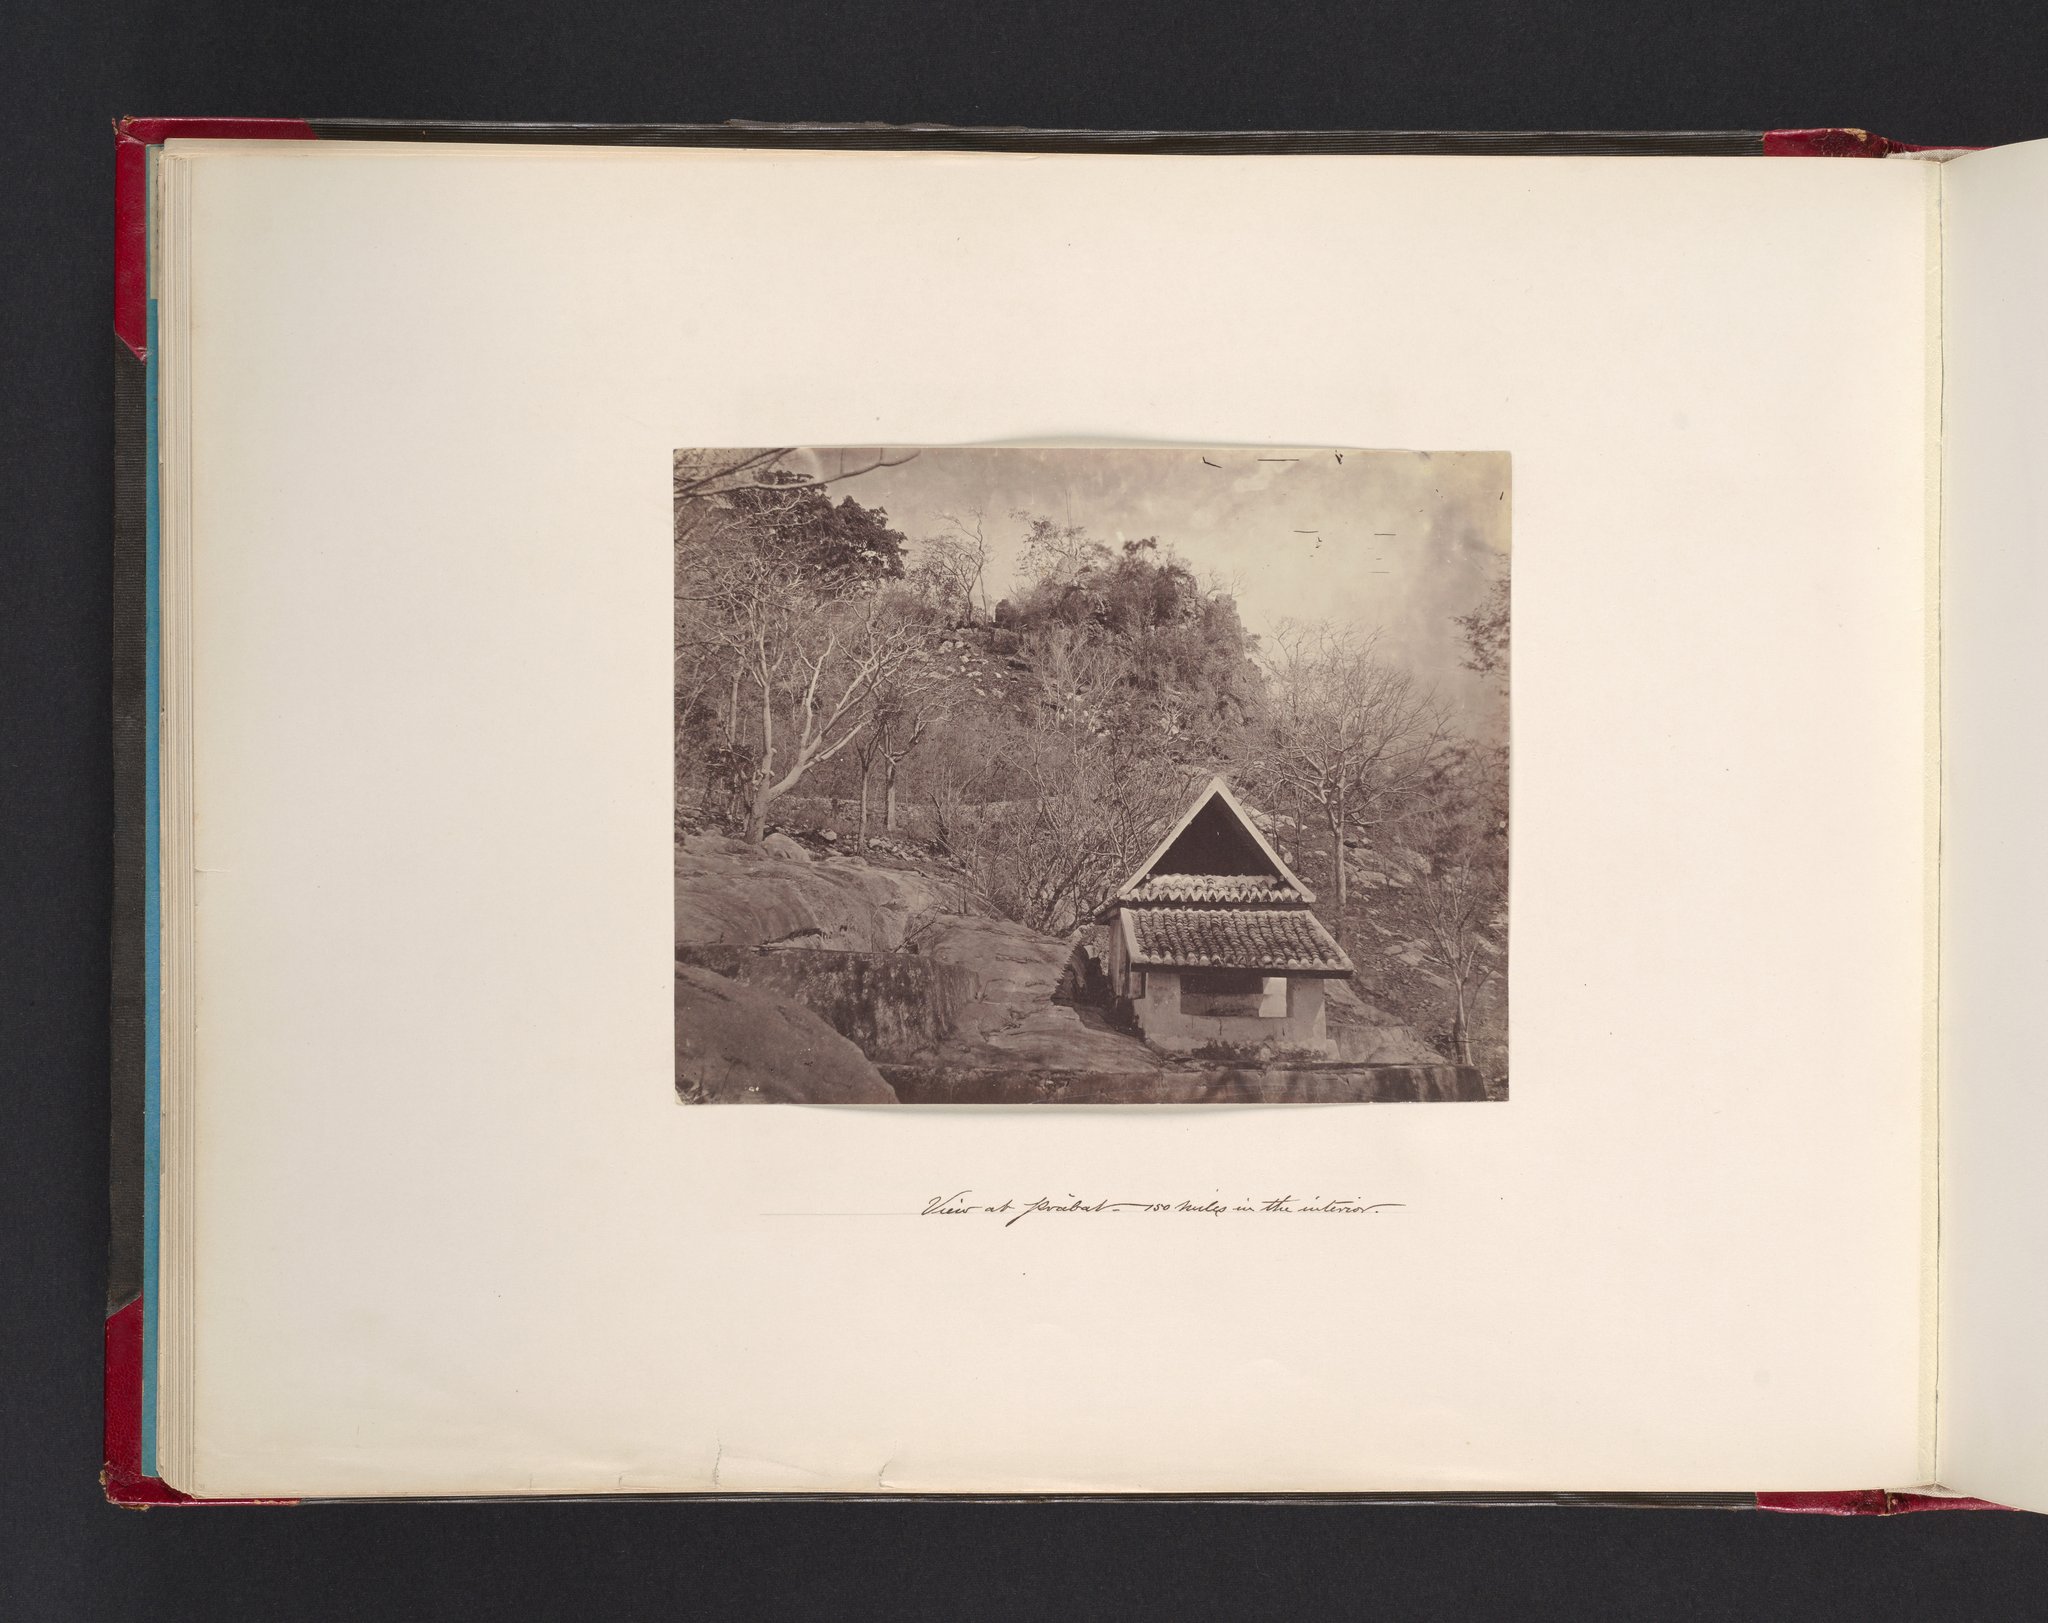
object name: photograph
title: [150 miles in the interior]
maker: john thomson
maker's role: artist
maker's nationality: british, scottish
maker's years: 1837-1921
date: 1865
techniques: albumen silver print, glass negative